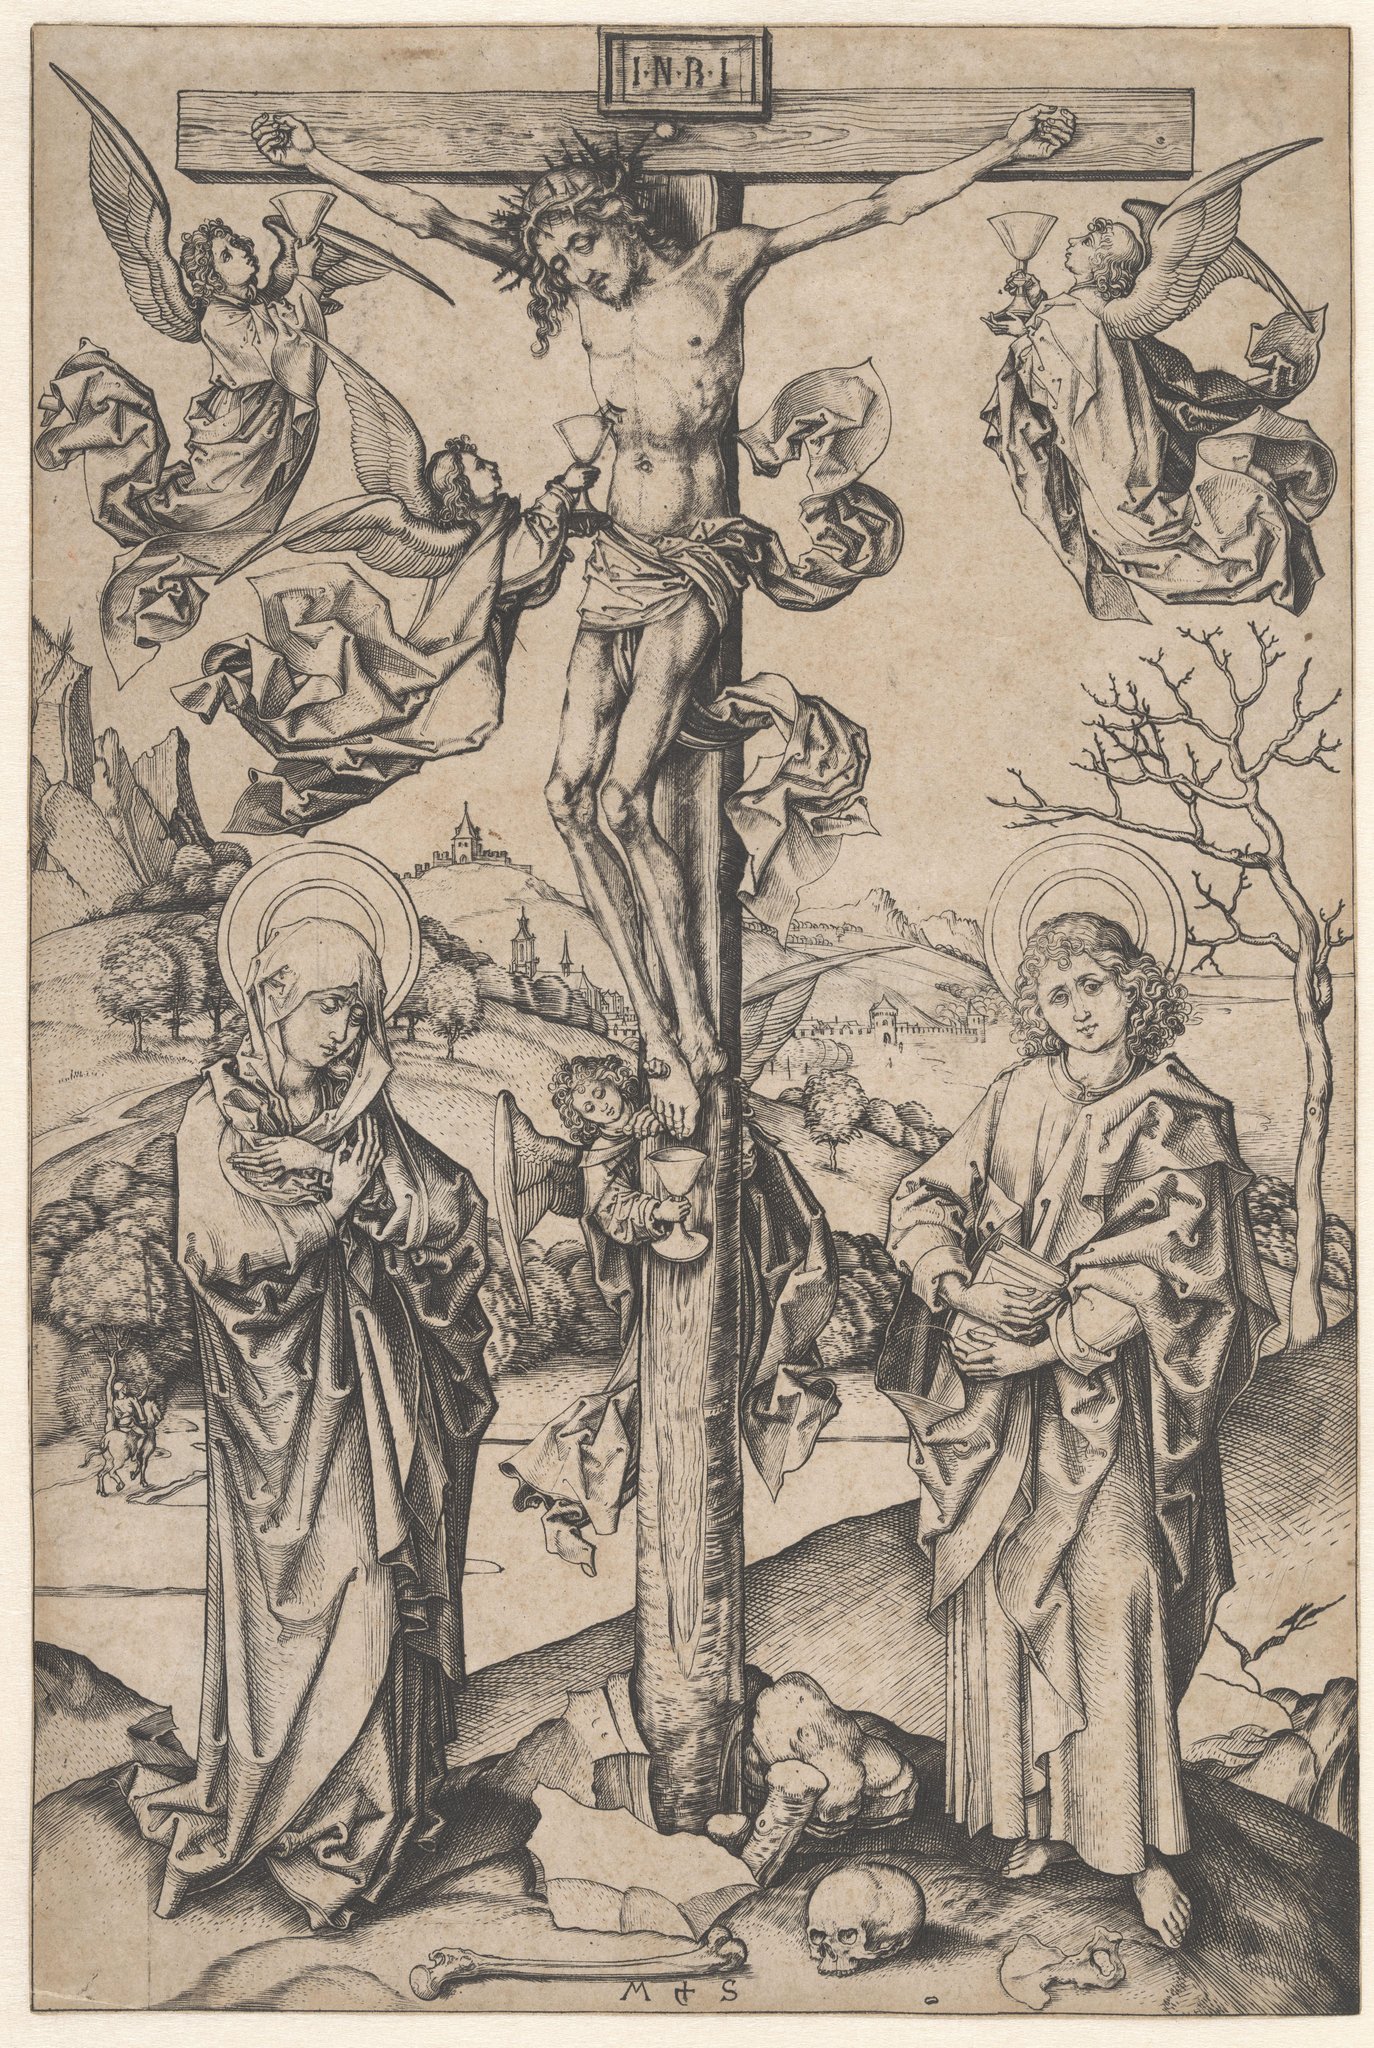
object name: print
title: The Crucifixion with four Angels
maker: martin schongauer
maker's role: print maker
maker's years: 1430-1491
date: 1480-1485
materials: ink, paper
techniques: drawing, engraving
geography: germany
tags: crucified christ with mary and john on either side of the cross; holy rood (+ angel(s)), angel(s) catching christ's blood in cup(s), angel(s) with chalice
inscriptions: collector's mark: Lugt 2228, collector's mark: Lugt 2760, inscription: ‘P. 7 (?); 7. B.M. (?)’, watermark: ‘Kop in profiel (L72)’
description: Martin Schongauer is the greatest printmaker of the late Middle Ages. This recently discovered impression of his Crucifixion is one of his most beautiful and best-preserved works. Christ’s wasted body and face were cut in the copper plate in extremely fine lines. Mary, John and the four angels who catch His blood exhibit the same sensitivity and delicacy.